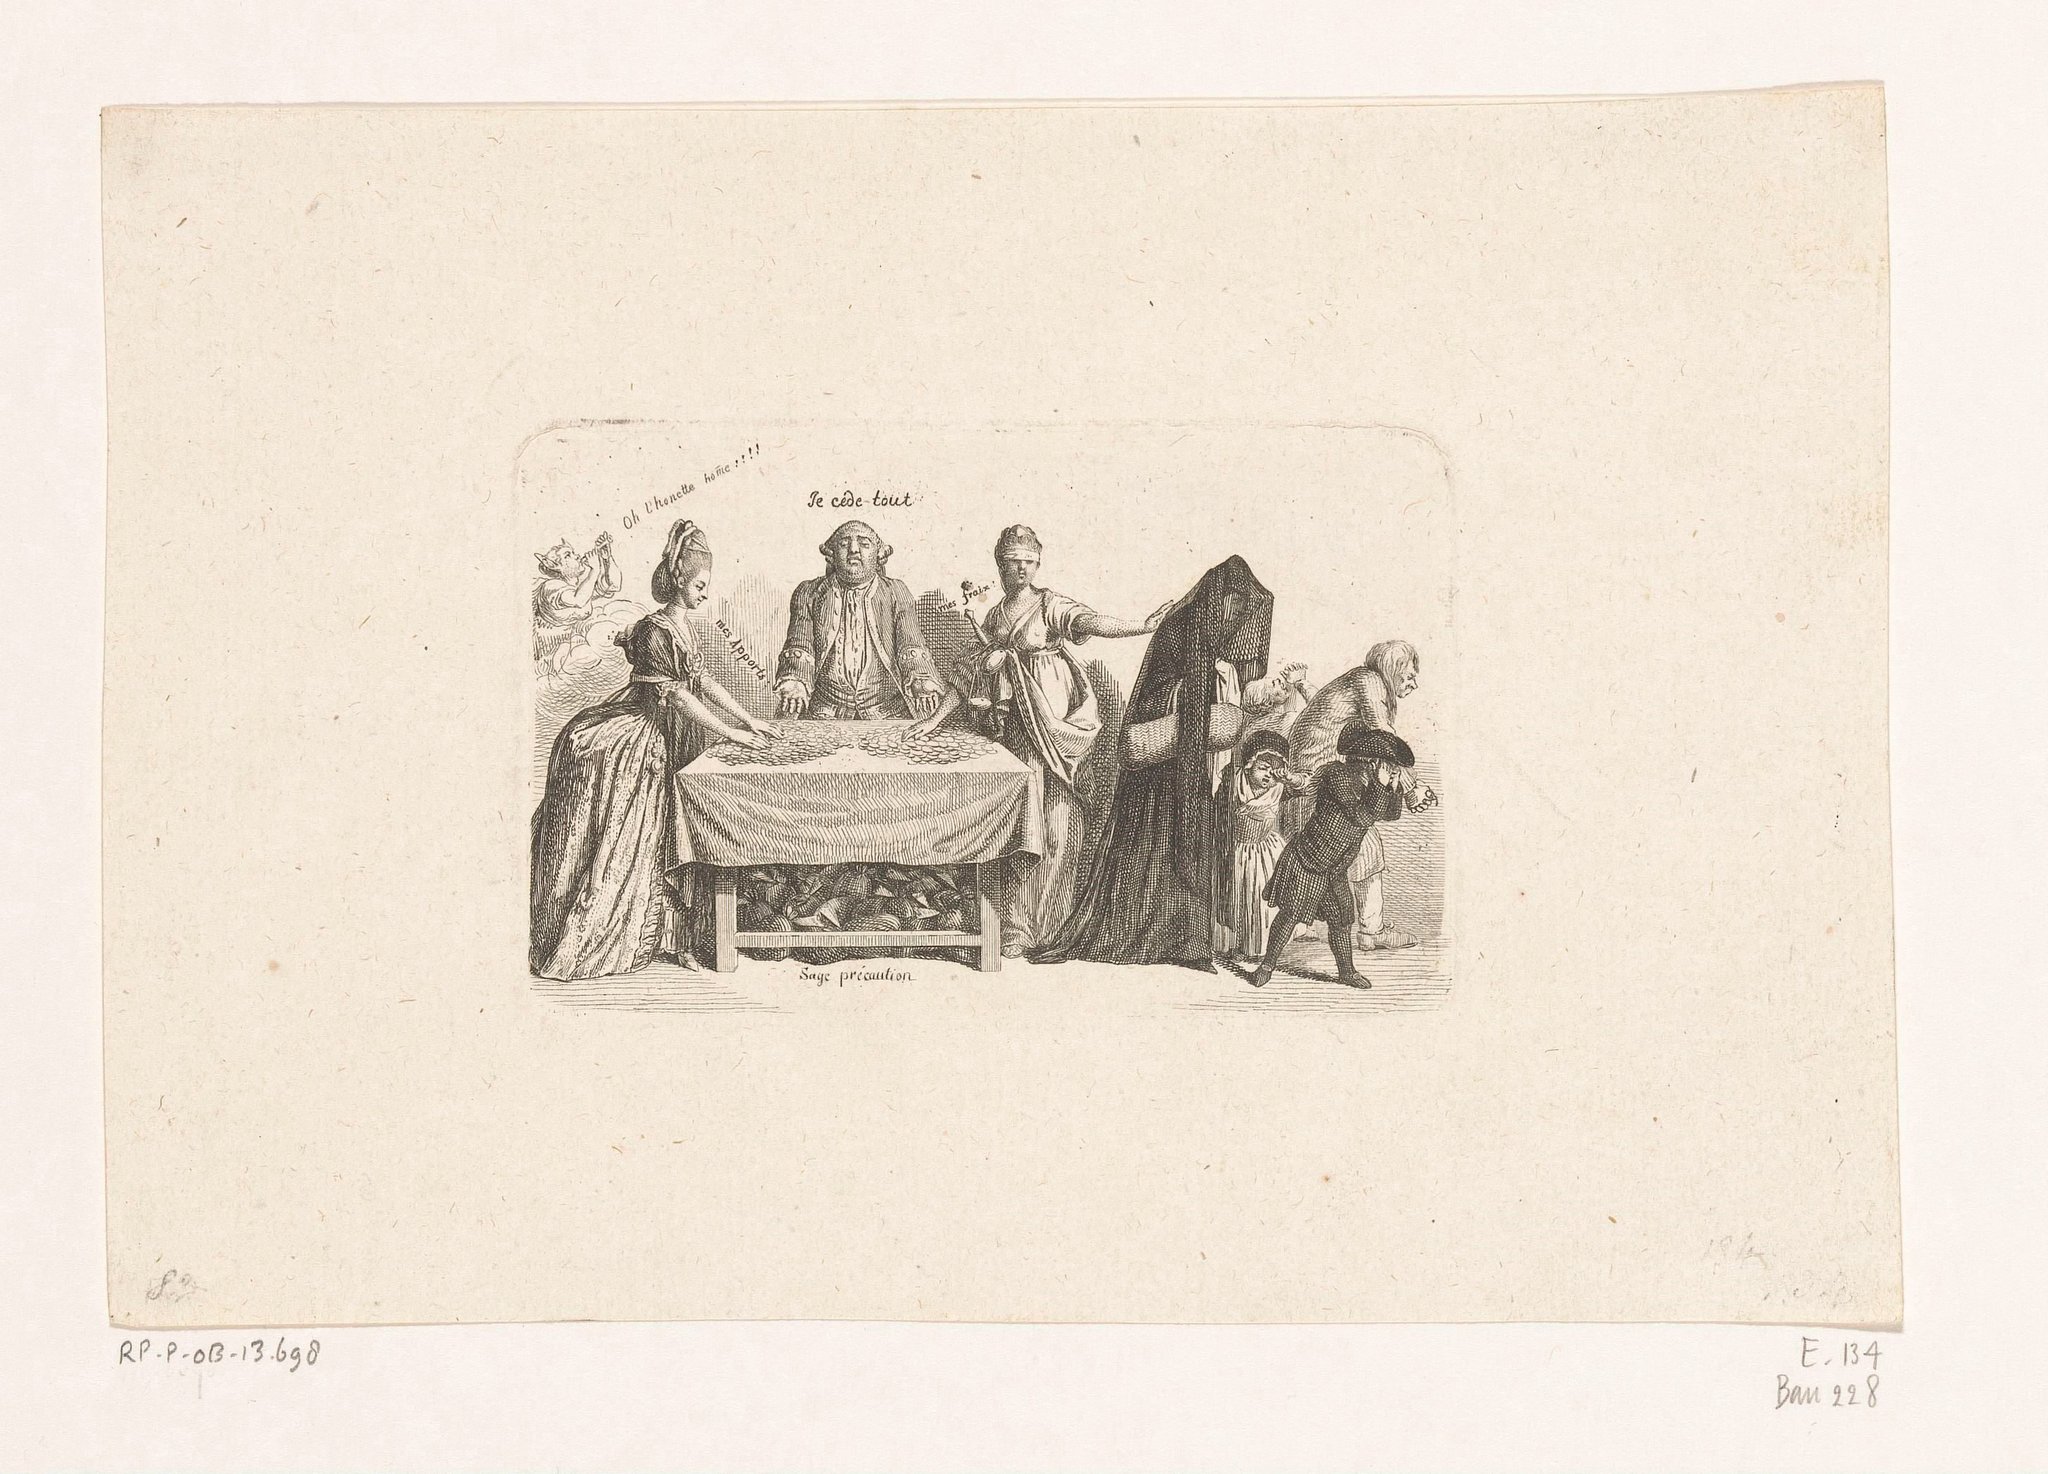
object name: print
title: Bankroet echtpaar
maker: daniel nikolaus chodowiecki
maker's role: draughtsman, print maker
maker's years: 1726-1801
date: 1775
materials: paper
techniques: etching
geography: berlin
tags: bankruptcy, justitia (justice) as roman personification, stupidity, poverty of intellect; 'stupidità overo stolidità' (ripa), money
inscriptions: collector's mark: Lugt 2228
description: Achter de tafel staat een man die bankroet is gegaan ('je céde tout'). Zijn vrouw eist haar bruidsschat op ('mes apports'). Ze weet niet dat haar man een deel van zijn fortuin voor haar achter houdt onder de tafel ('sage précaution'). Rechts pakt Jusitia enkele muntstukken van de tafel voor de kosten van de liquidatie ('mes fraix'). Met een andere hand stuurt ze twee een gesluierde weduwe, twee weeskinderen en twee schuldeisers weg. Links verheugt de Domheid zich op een wolk over de situatie ('Oh l'honnette homme!!!!').